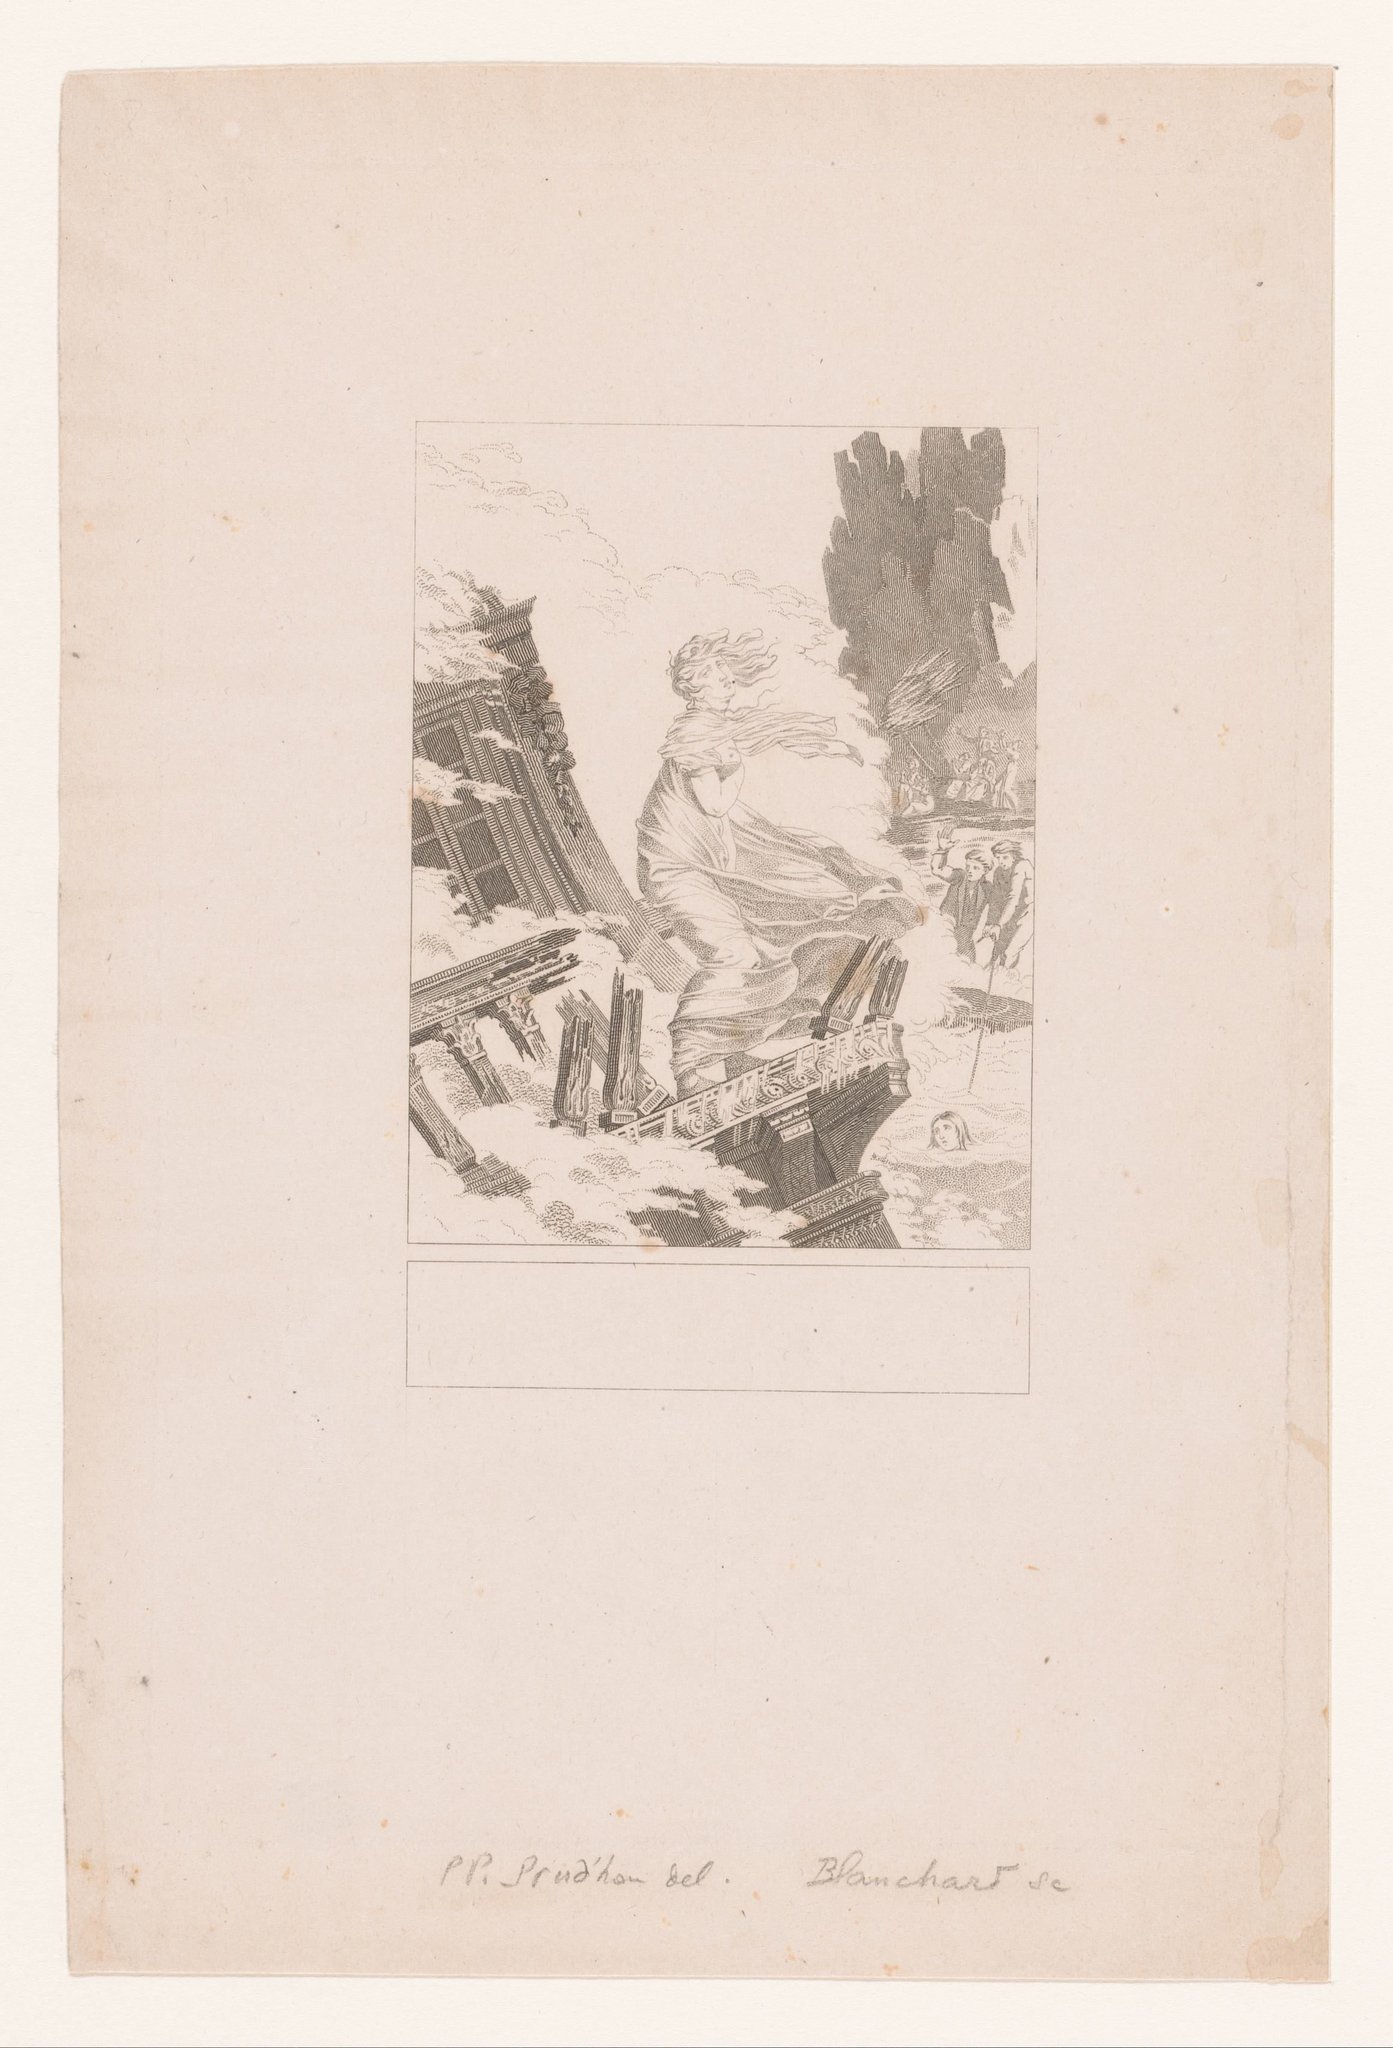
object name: print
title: Naufrage de Virgine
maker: auguste thomas marie blanchard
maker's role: print maker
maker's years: 1819-1898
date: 1829-1898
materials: paper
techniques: etching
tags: shipping accident; sickness and death at sea, (scenes from) specific works of literature: bernardin de saint-pierre, paul et virginie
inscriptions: collector's mark: Lugt 2228